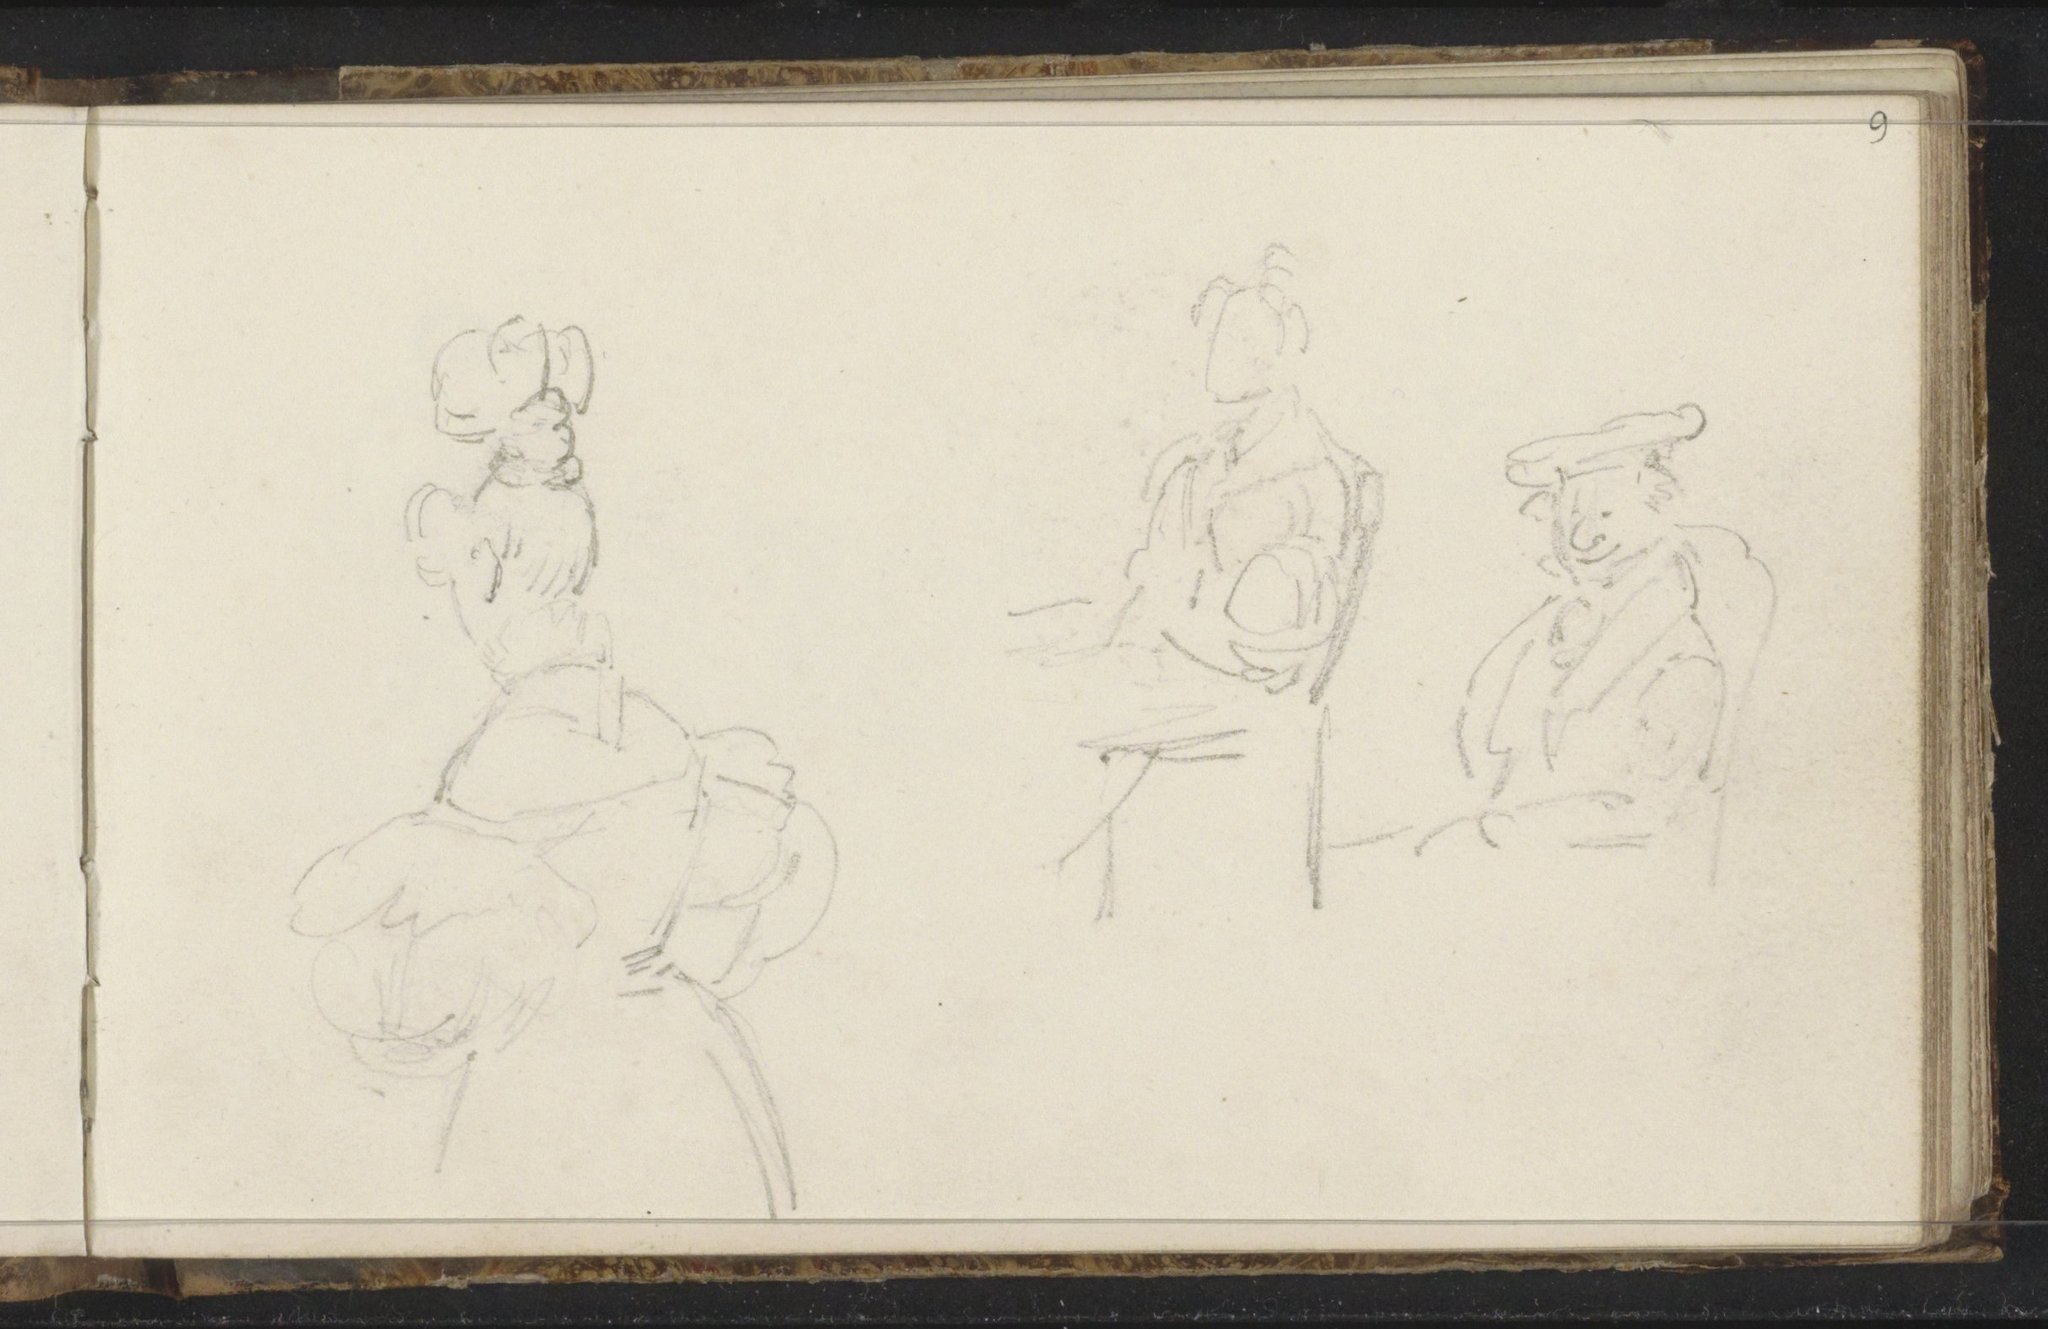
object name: sketchbook leaf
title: Staande vrouw en twee zittende mannen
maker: willem hendrik schmidt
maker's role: draughtsman, painter, print maker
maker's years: 1809-1849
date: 1819-1849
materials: paper, pencil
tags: postures of the human figure, standing figure - aa - female human figure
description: Blad 9 recto uit een schetsboek met 60 bladen.